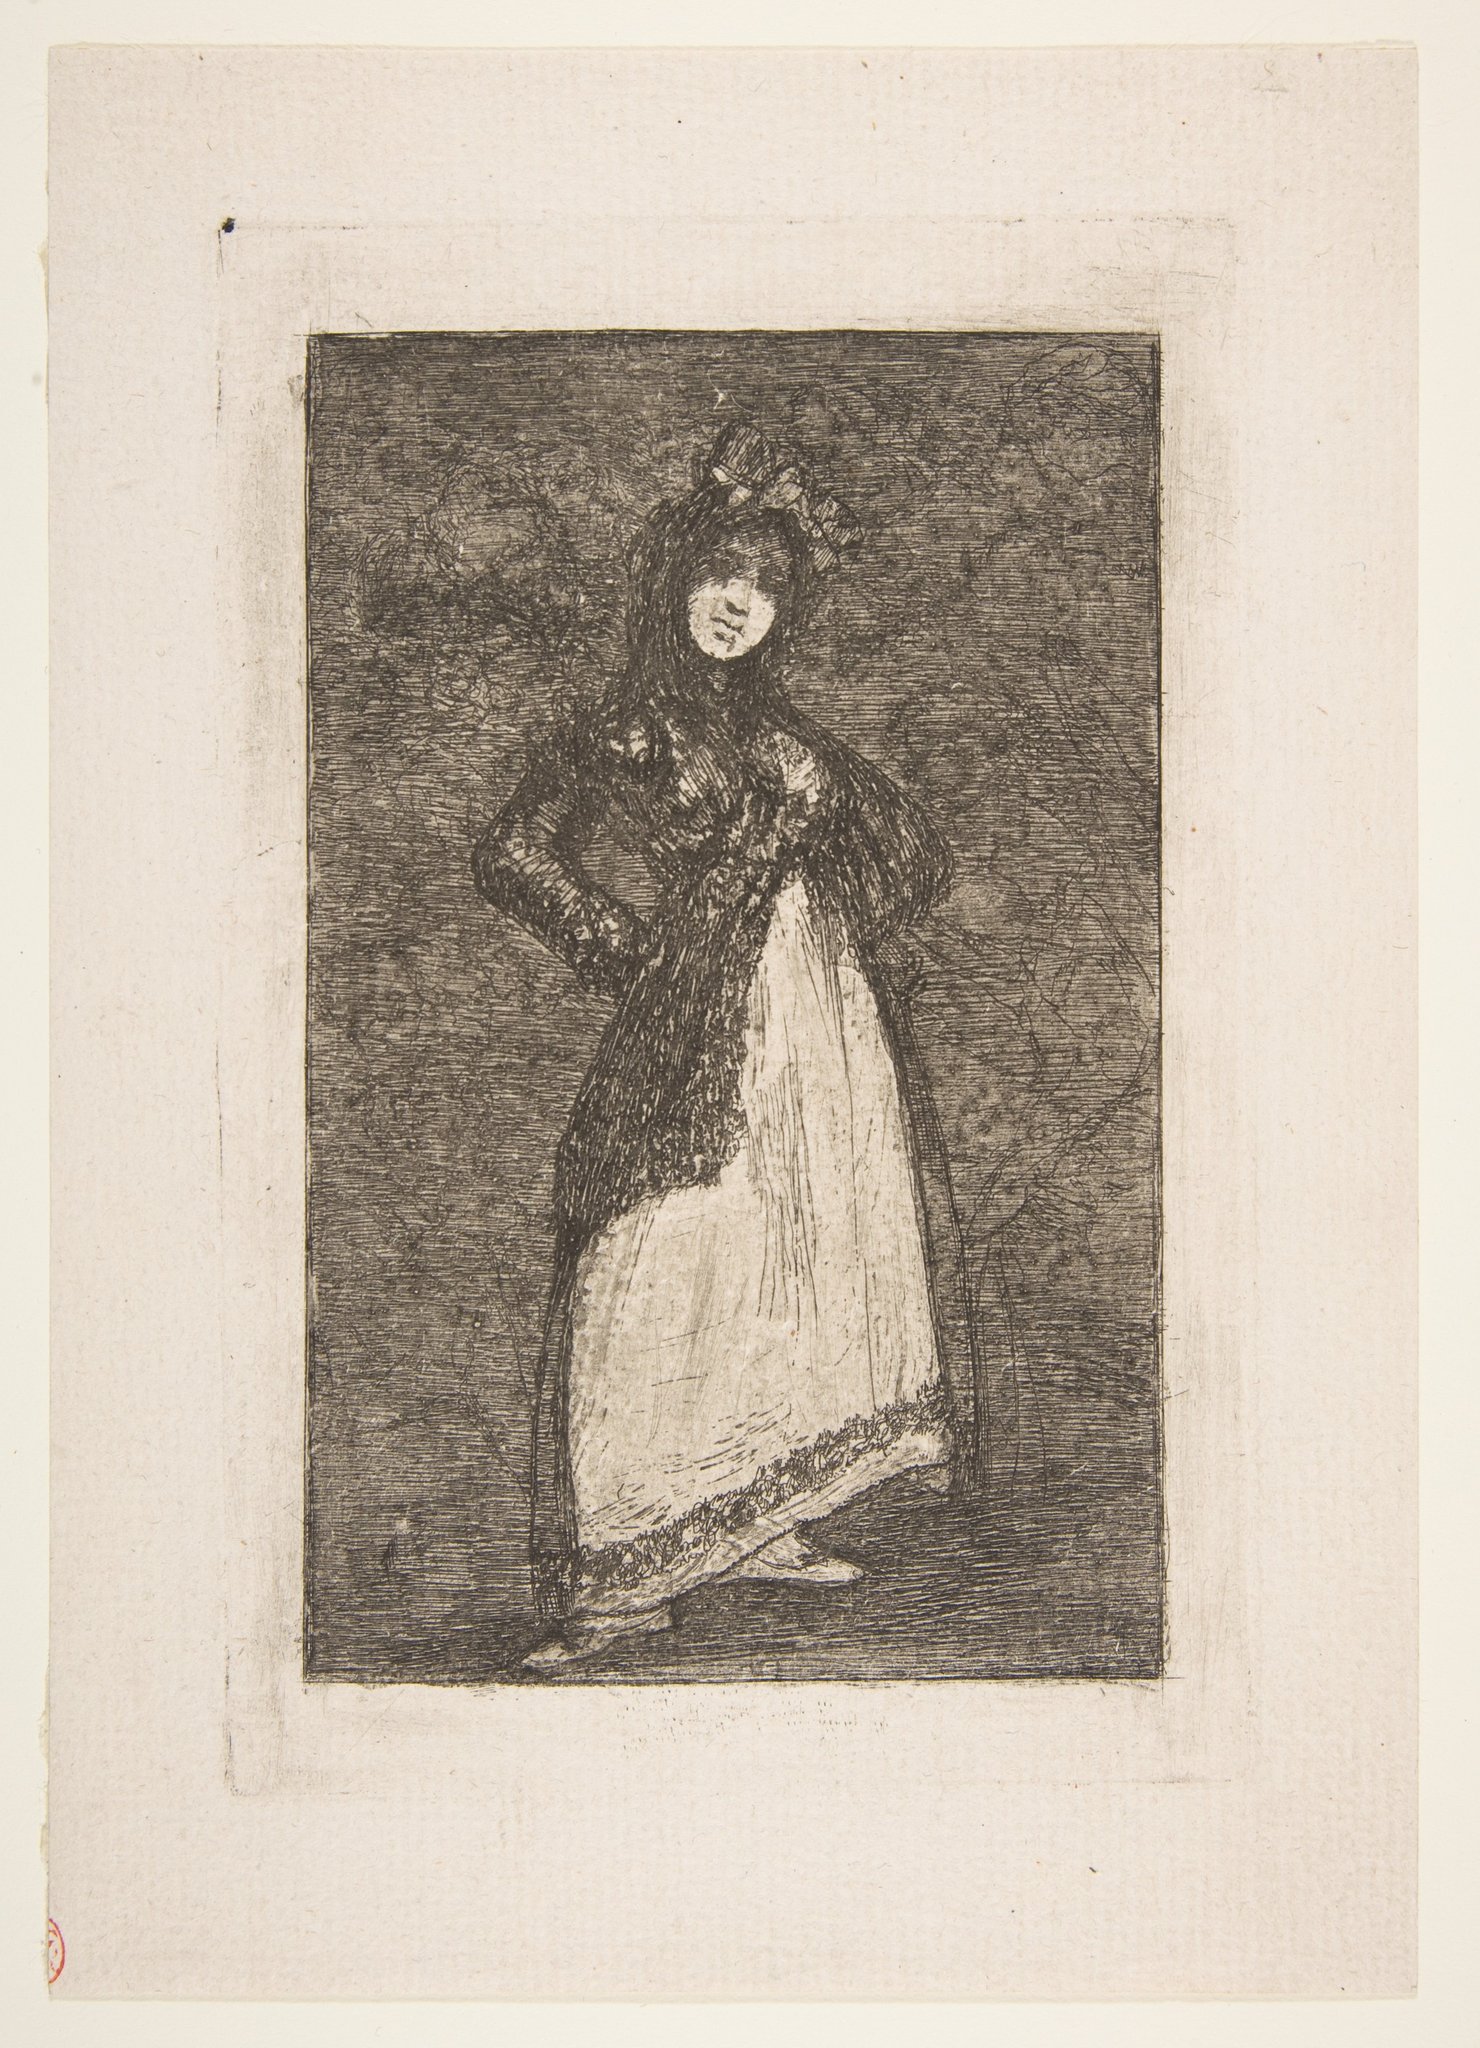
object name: print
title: A Maja standing against a dark background with figures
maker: goya (francisco de goya y lucientes)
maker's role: artist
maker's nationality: spanish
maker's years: 1746-1828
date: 1859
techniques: aquatint, etching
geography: spain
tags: women